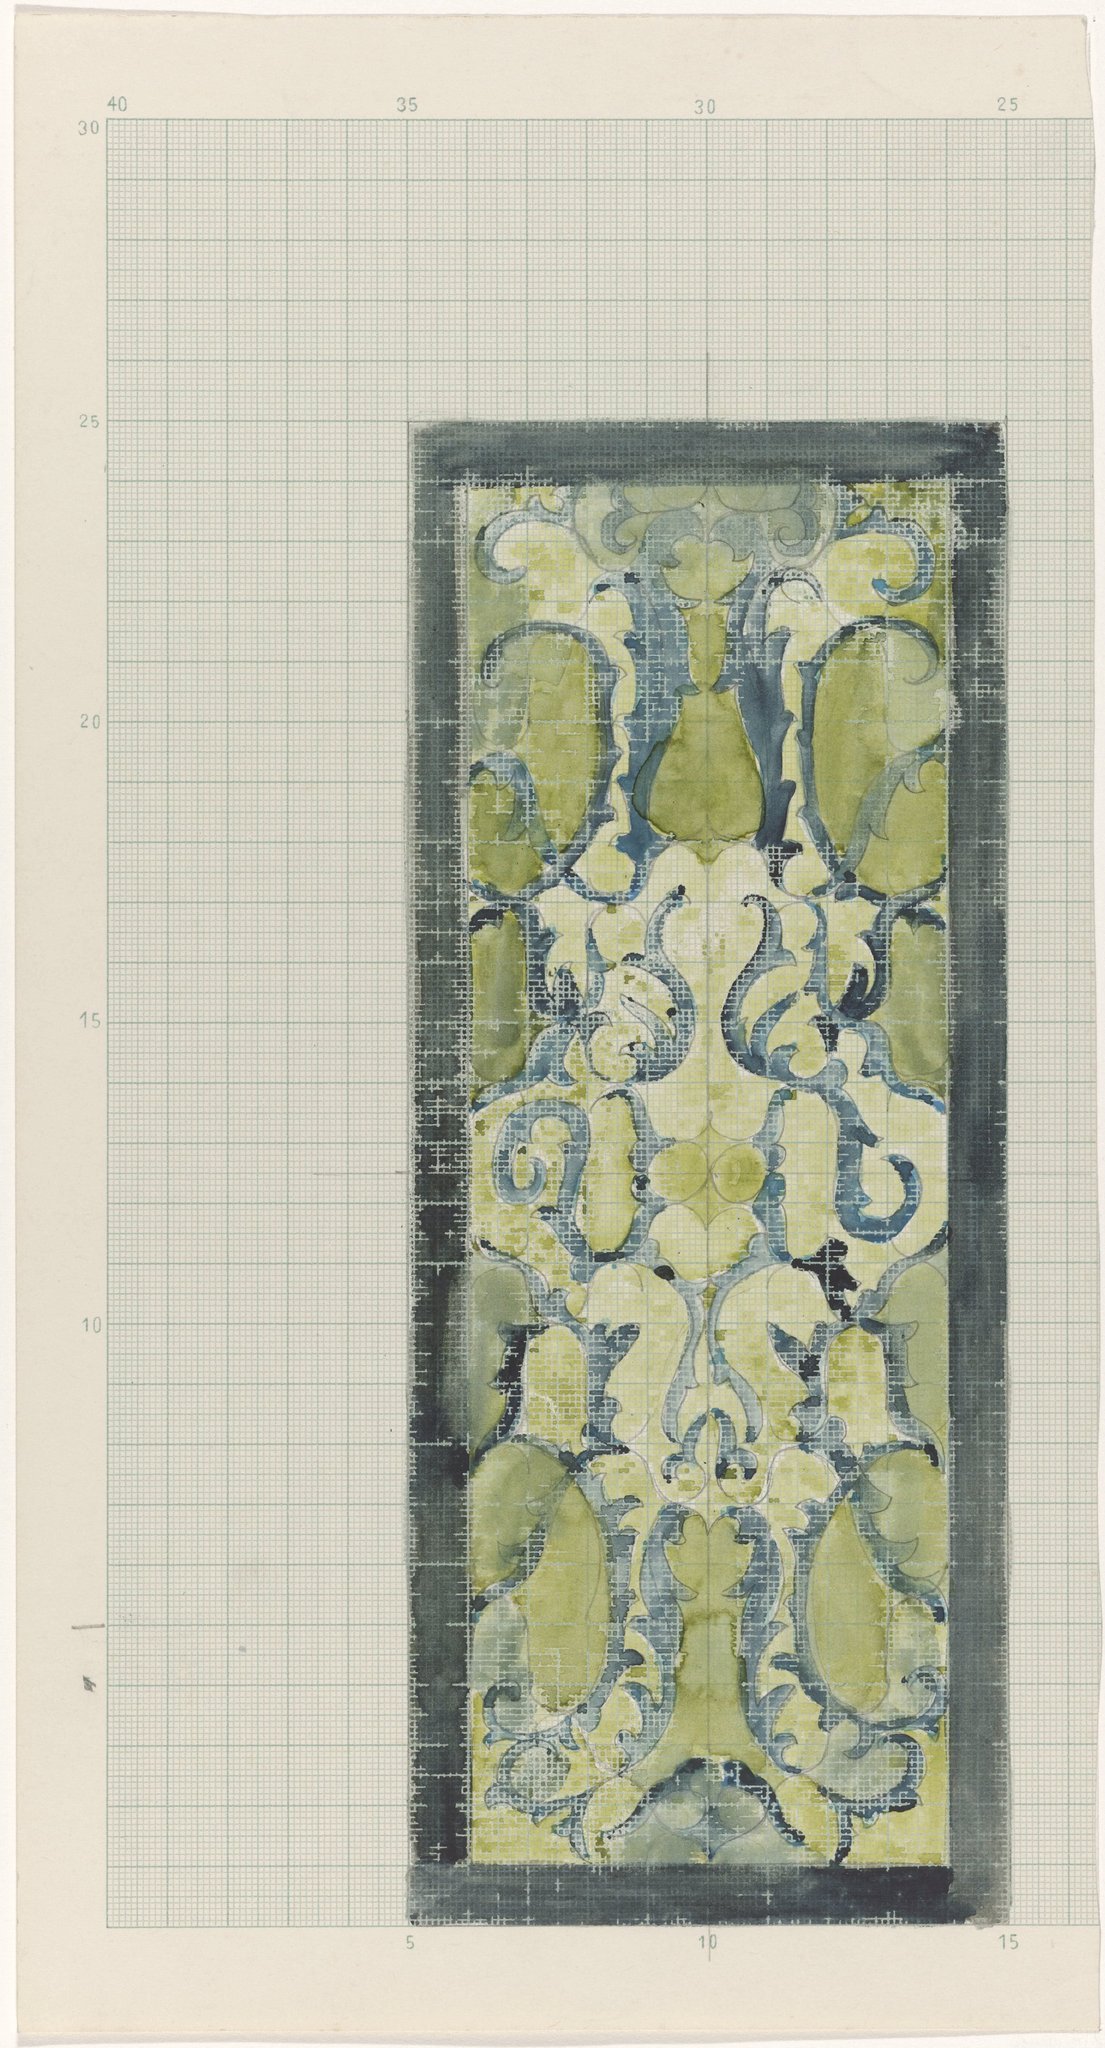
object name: design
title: Decoratief ontwerp in groen en blauw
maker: carel adolph lion cachet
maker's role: draughtsman, print maker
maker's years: 1864-1945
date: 1874-1945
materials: pencil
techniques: brush